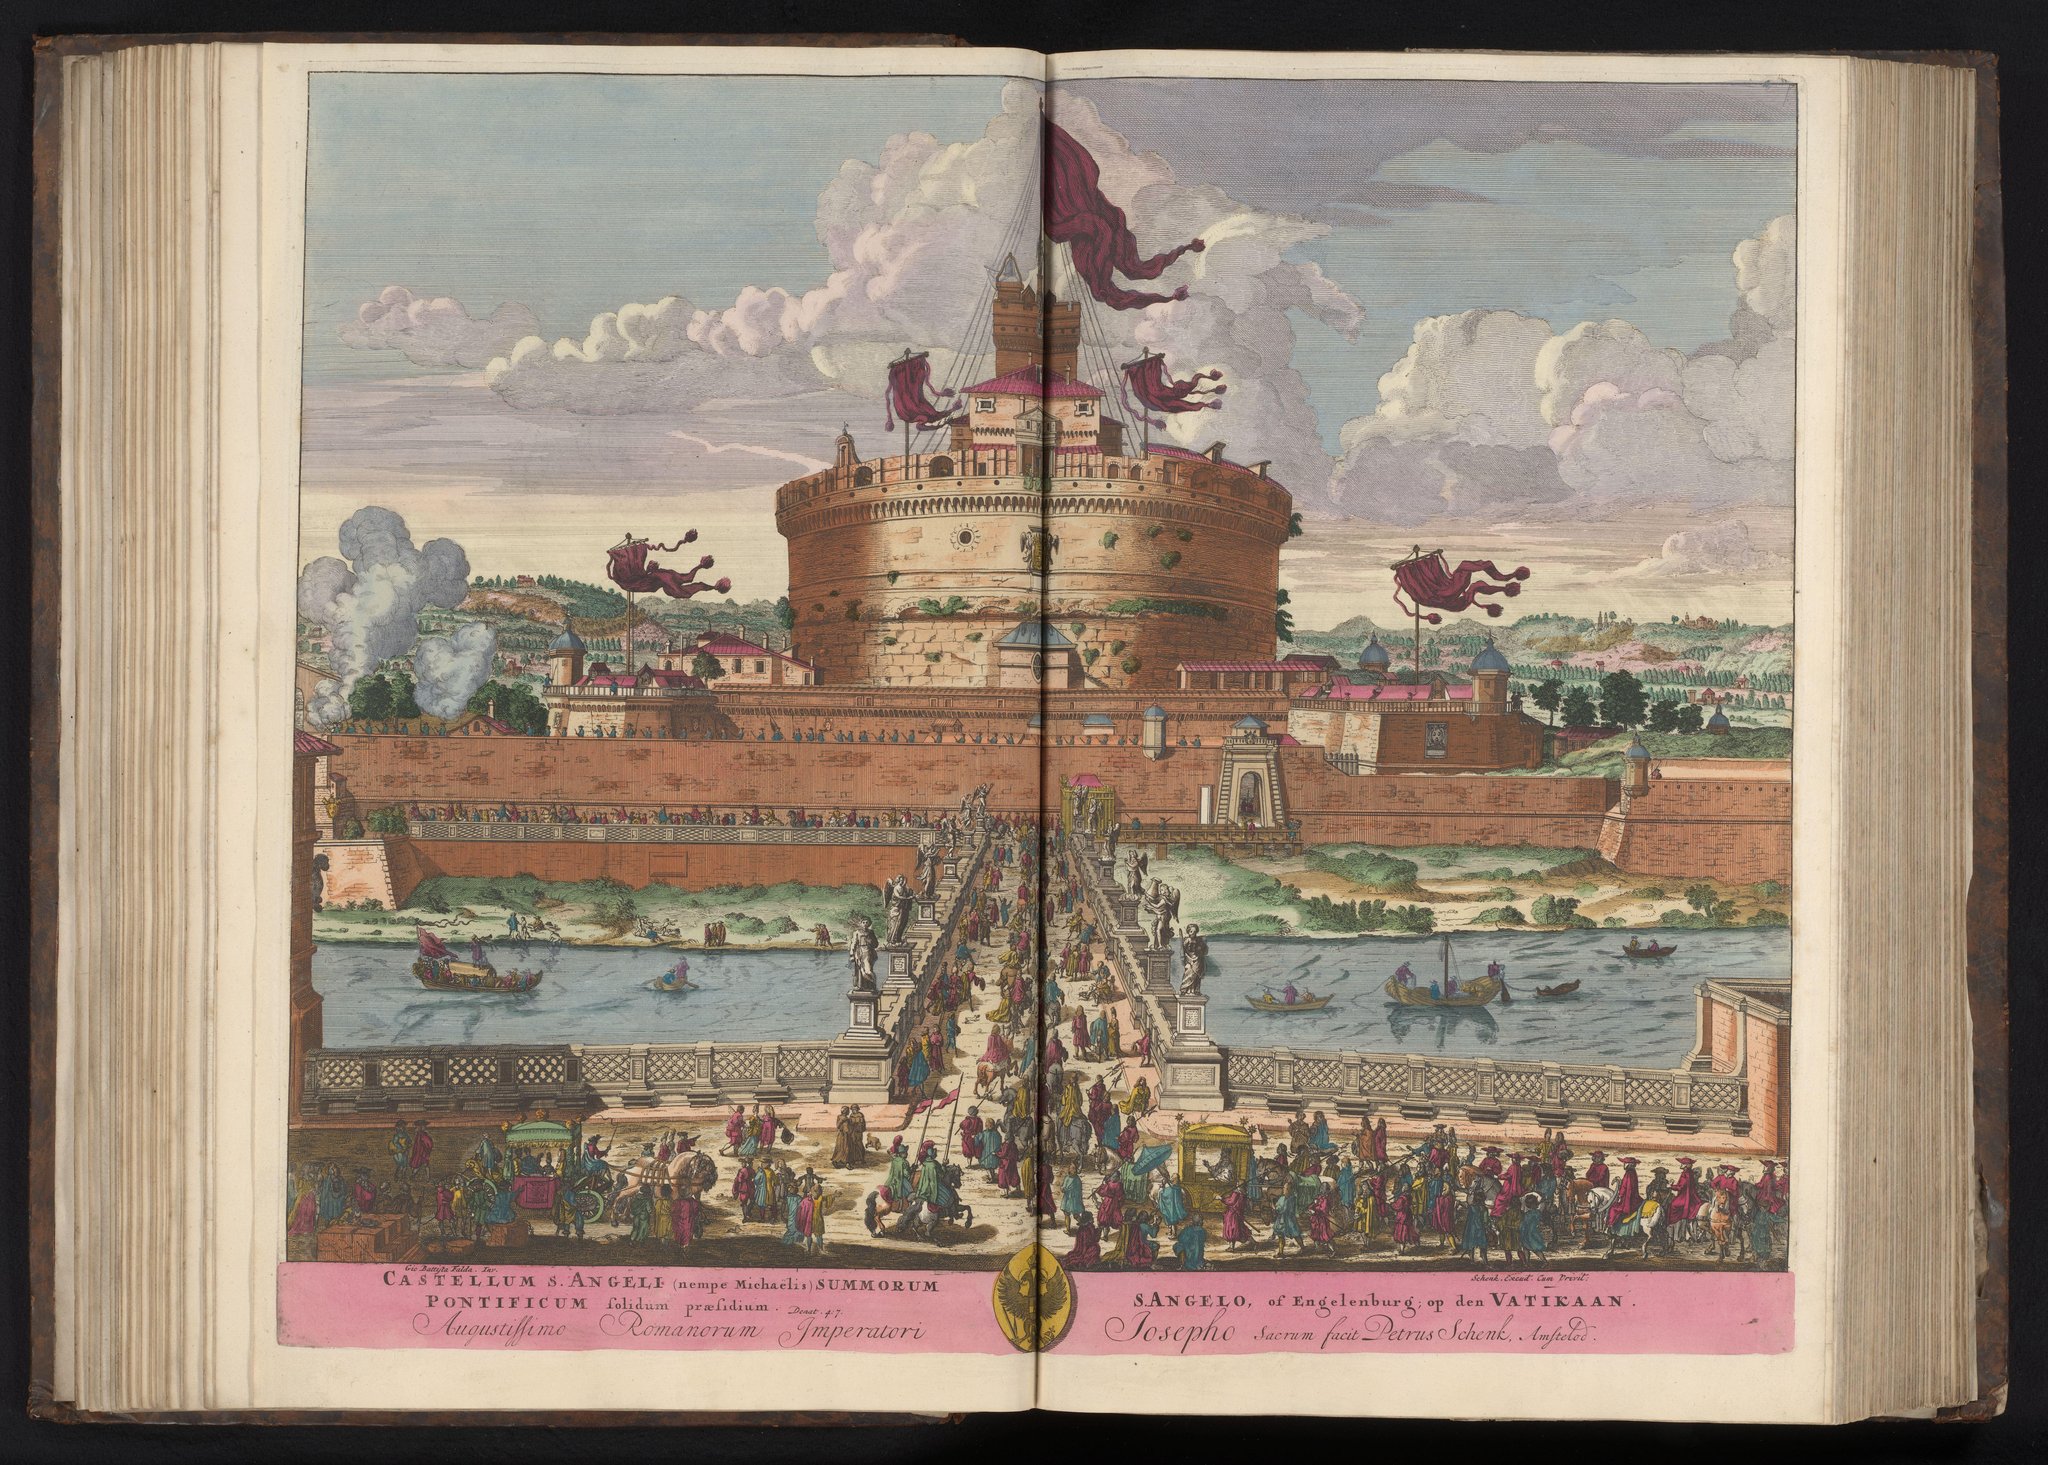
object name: album leaf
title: Castellum S. Angeli (nempe Michaëlis) summorum (...)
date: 1675-1711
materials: paper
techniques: colour, etching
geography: amsterdam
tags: fortress, city-view, and landscape with man-made constructions, bridge in city across river, canal, etc. (+ city(-scape) with figures, staffage), river, bridge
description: Gezicht op de Engelenburcht en de Engelenbrug over de rivier de Tiber te Rome. In de ondermarge de titel en opdracht in het Latijn. Prent maakt deel uit van een album.